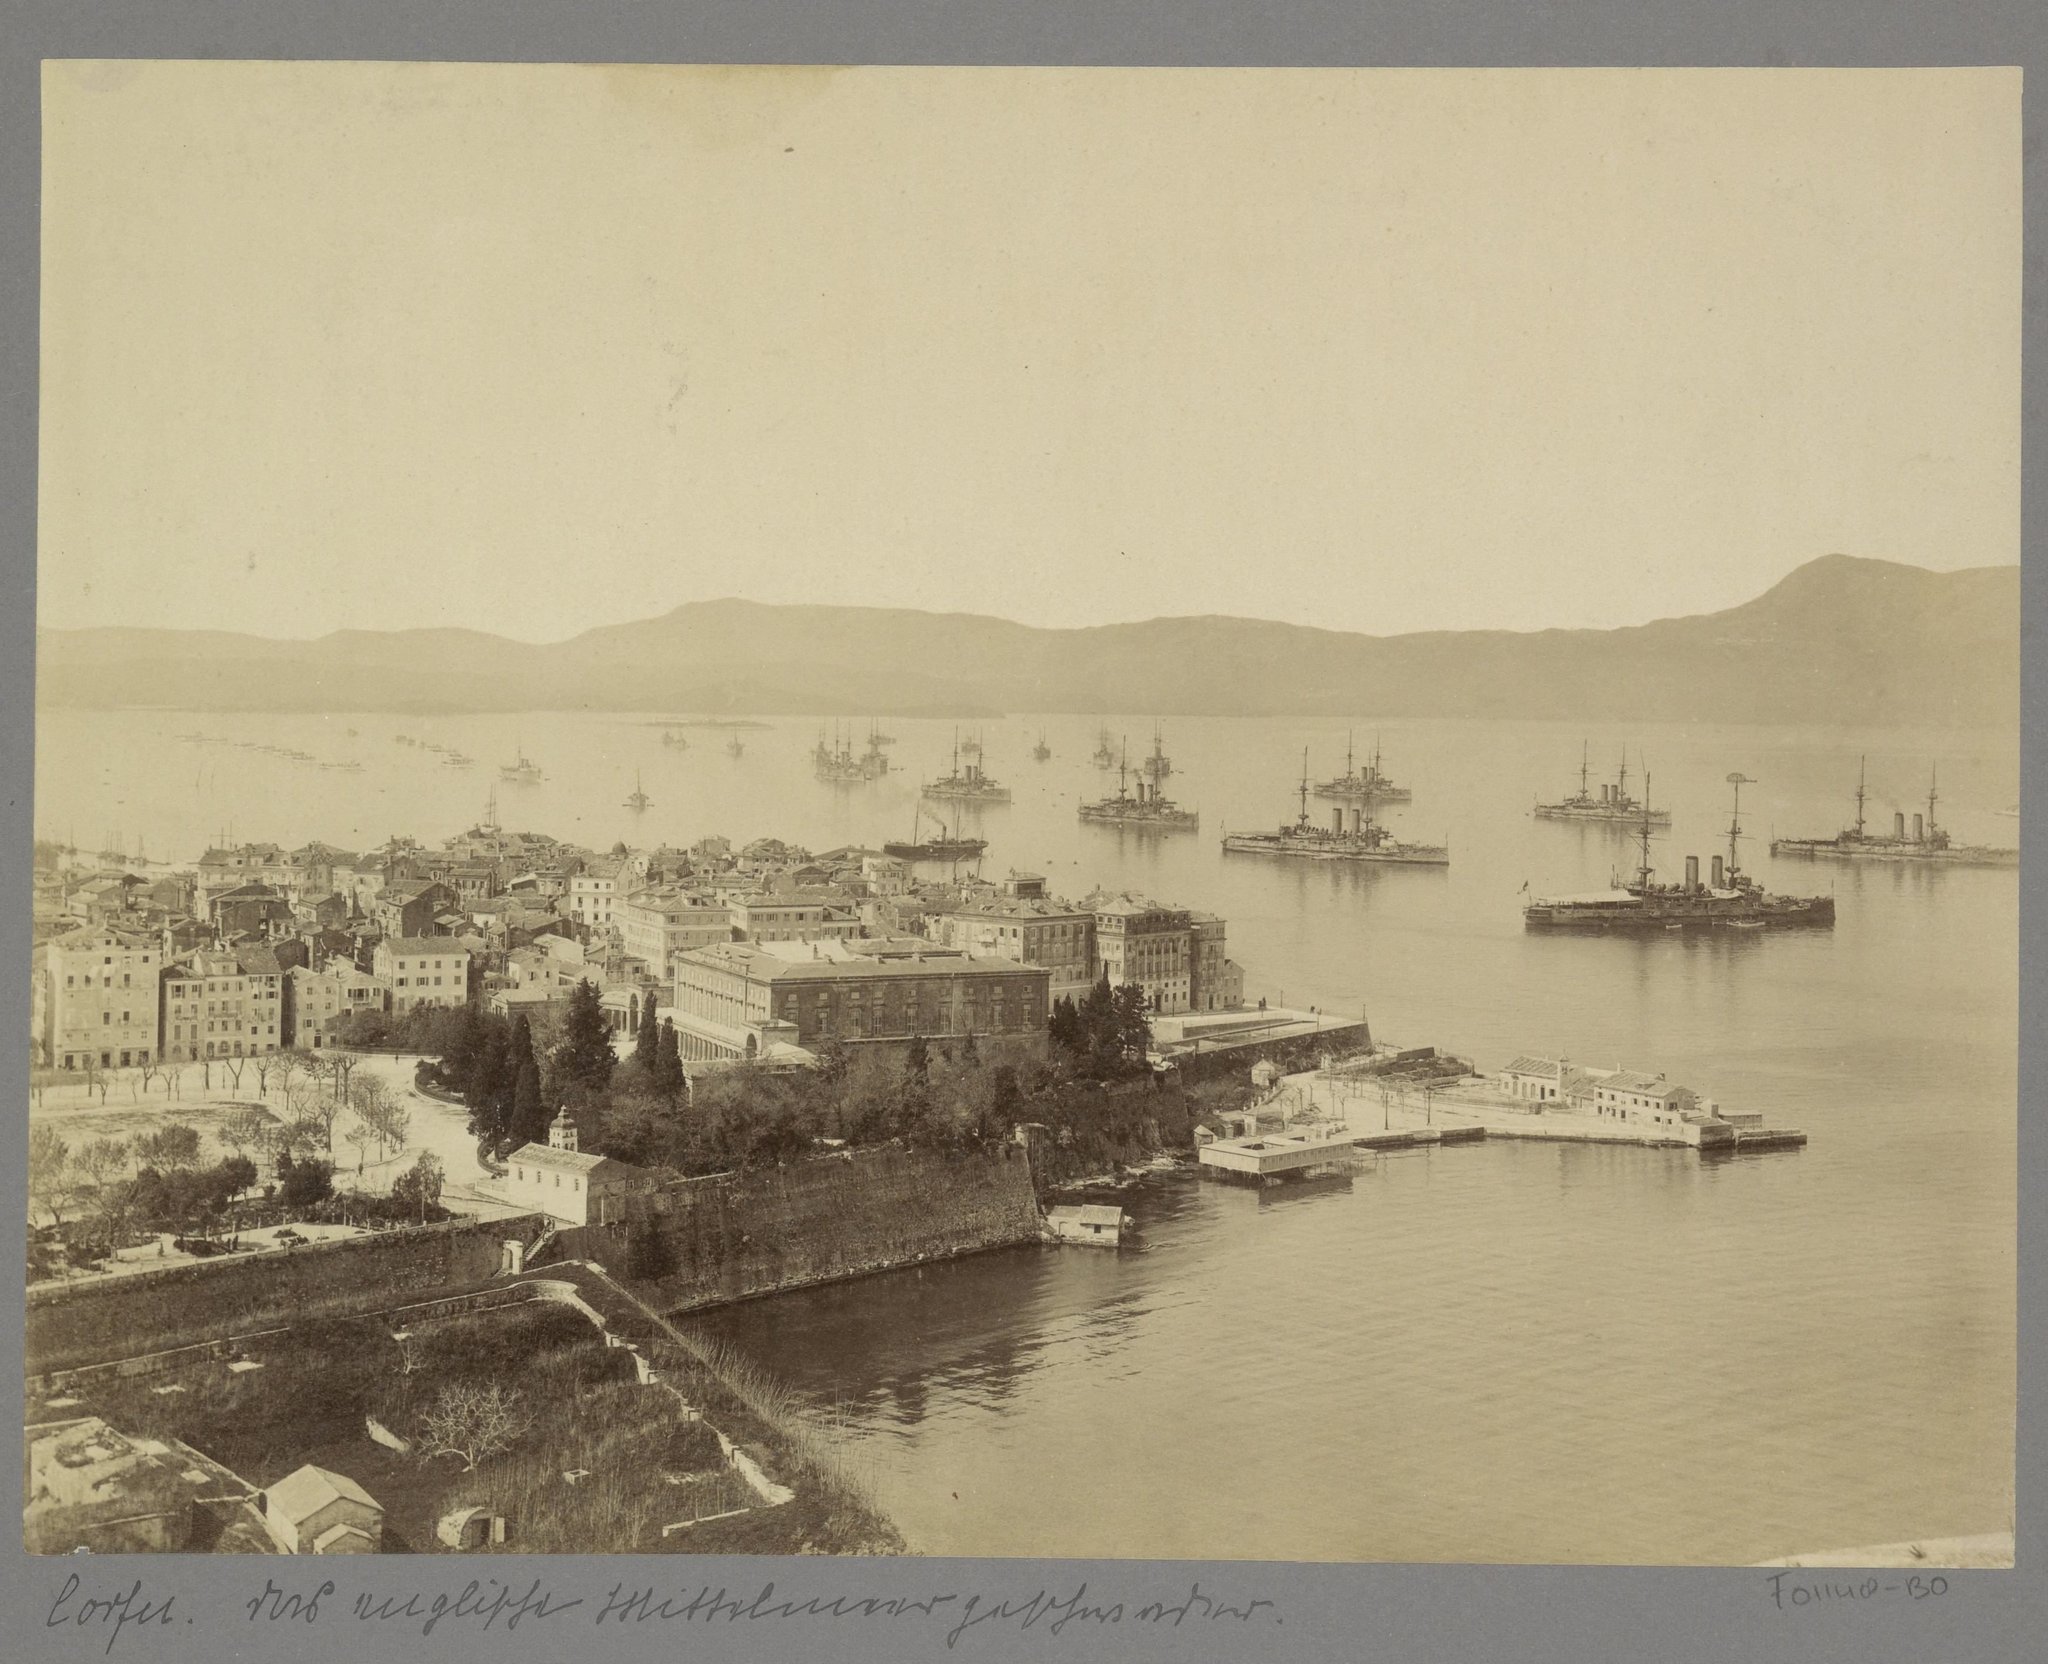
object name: album leaf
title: Gezicht op een vlooteskader bij de stad Corfu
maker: Anonymous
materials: paper, photographic support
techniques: albumen print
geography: corfu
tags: sailing-ship, sailing-boat (with name), prospect of city, town panorama, silhouette of city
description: Onderdeel van Reisalbum met foto's van bezienswaardigheden in Griekenland en Egypte.